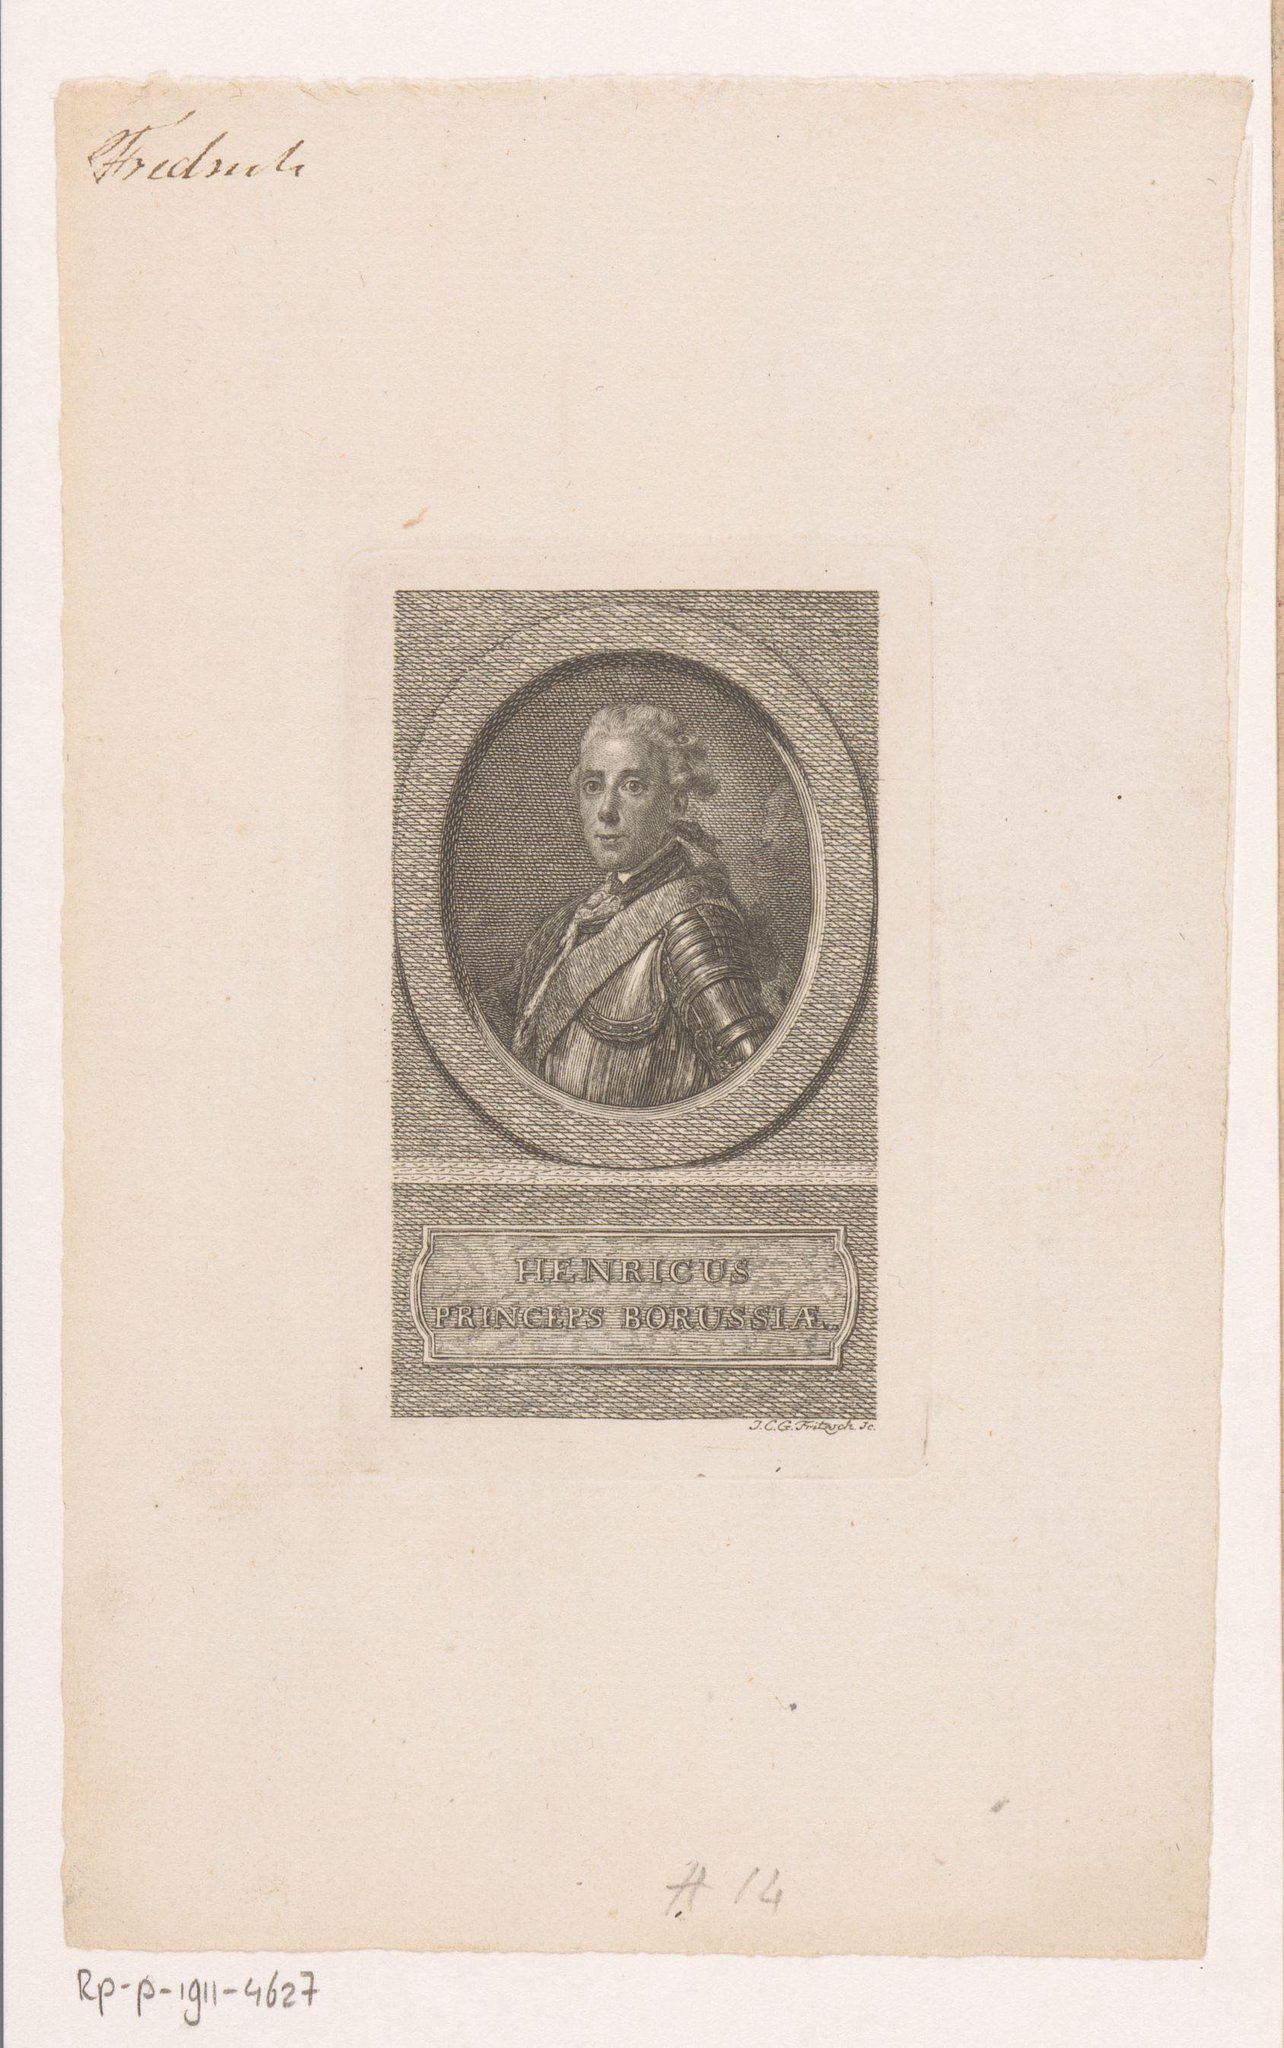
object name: print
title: Portret van Friedrich Heinrich Ludwig van Pruisen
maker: johann christian gottfried fritzsch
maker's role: print maker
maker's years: 1720-1802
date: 1736-1802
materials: paper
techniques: engraving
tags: friedrich heinrich ludwig van pruisen, armour, historical persons, ruler, sovereign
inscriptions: collector's mark: Lugt 2228